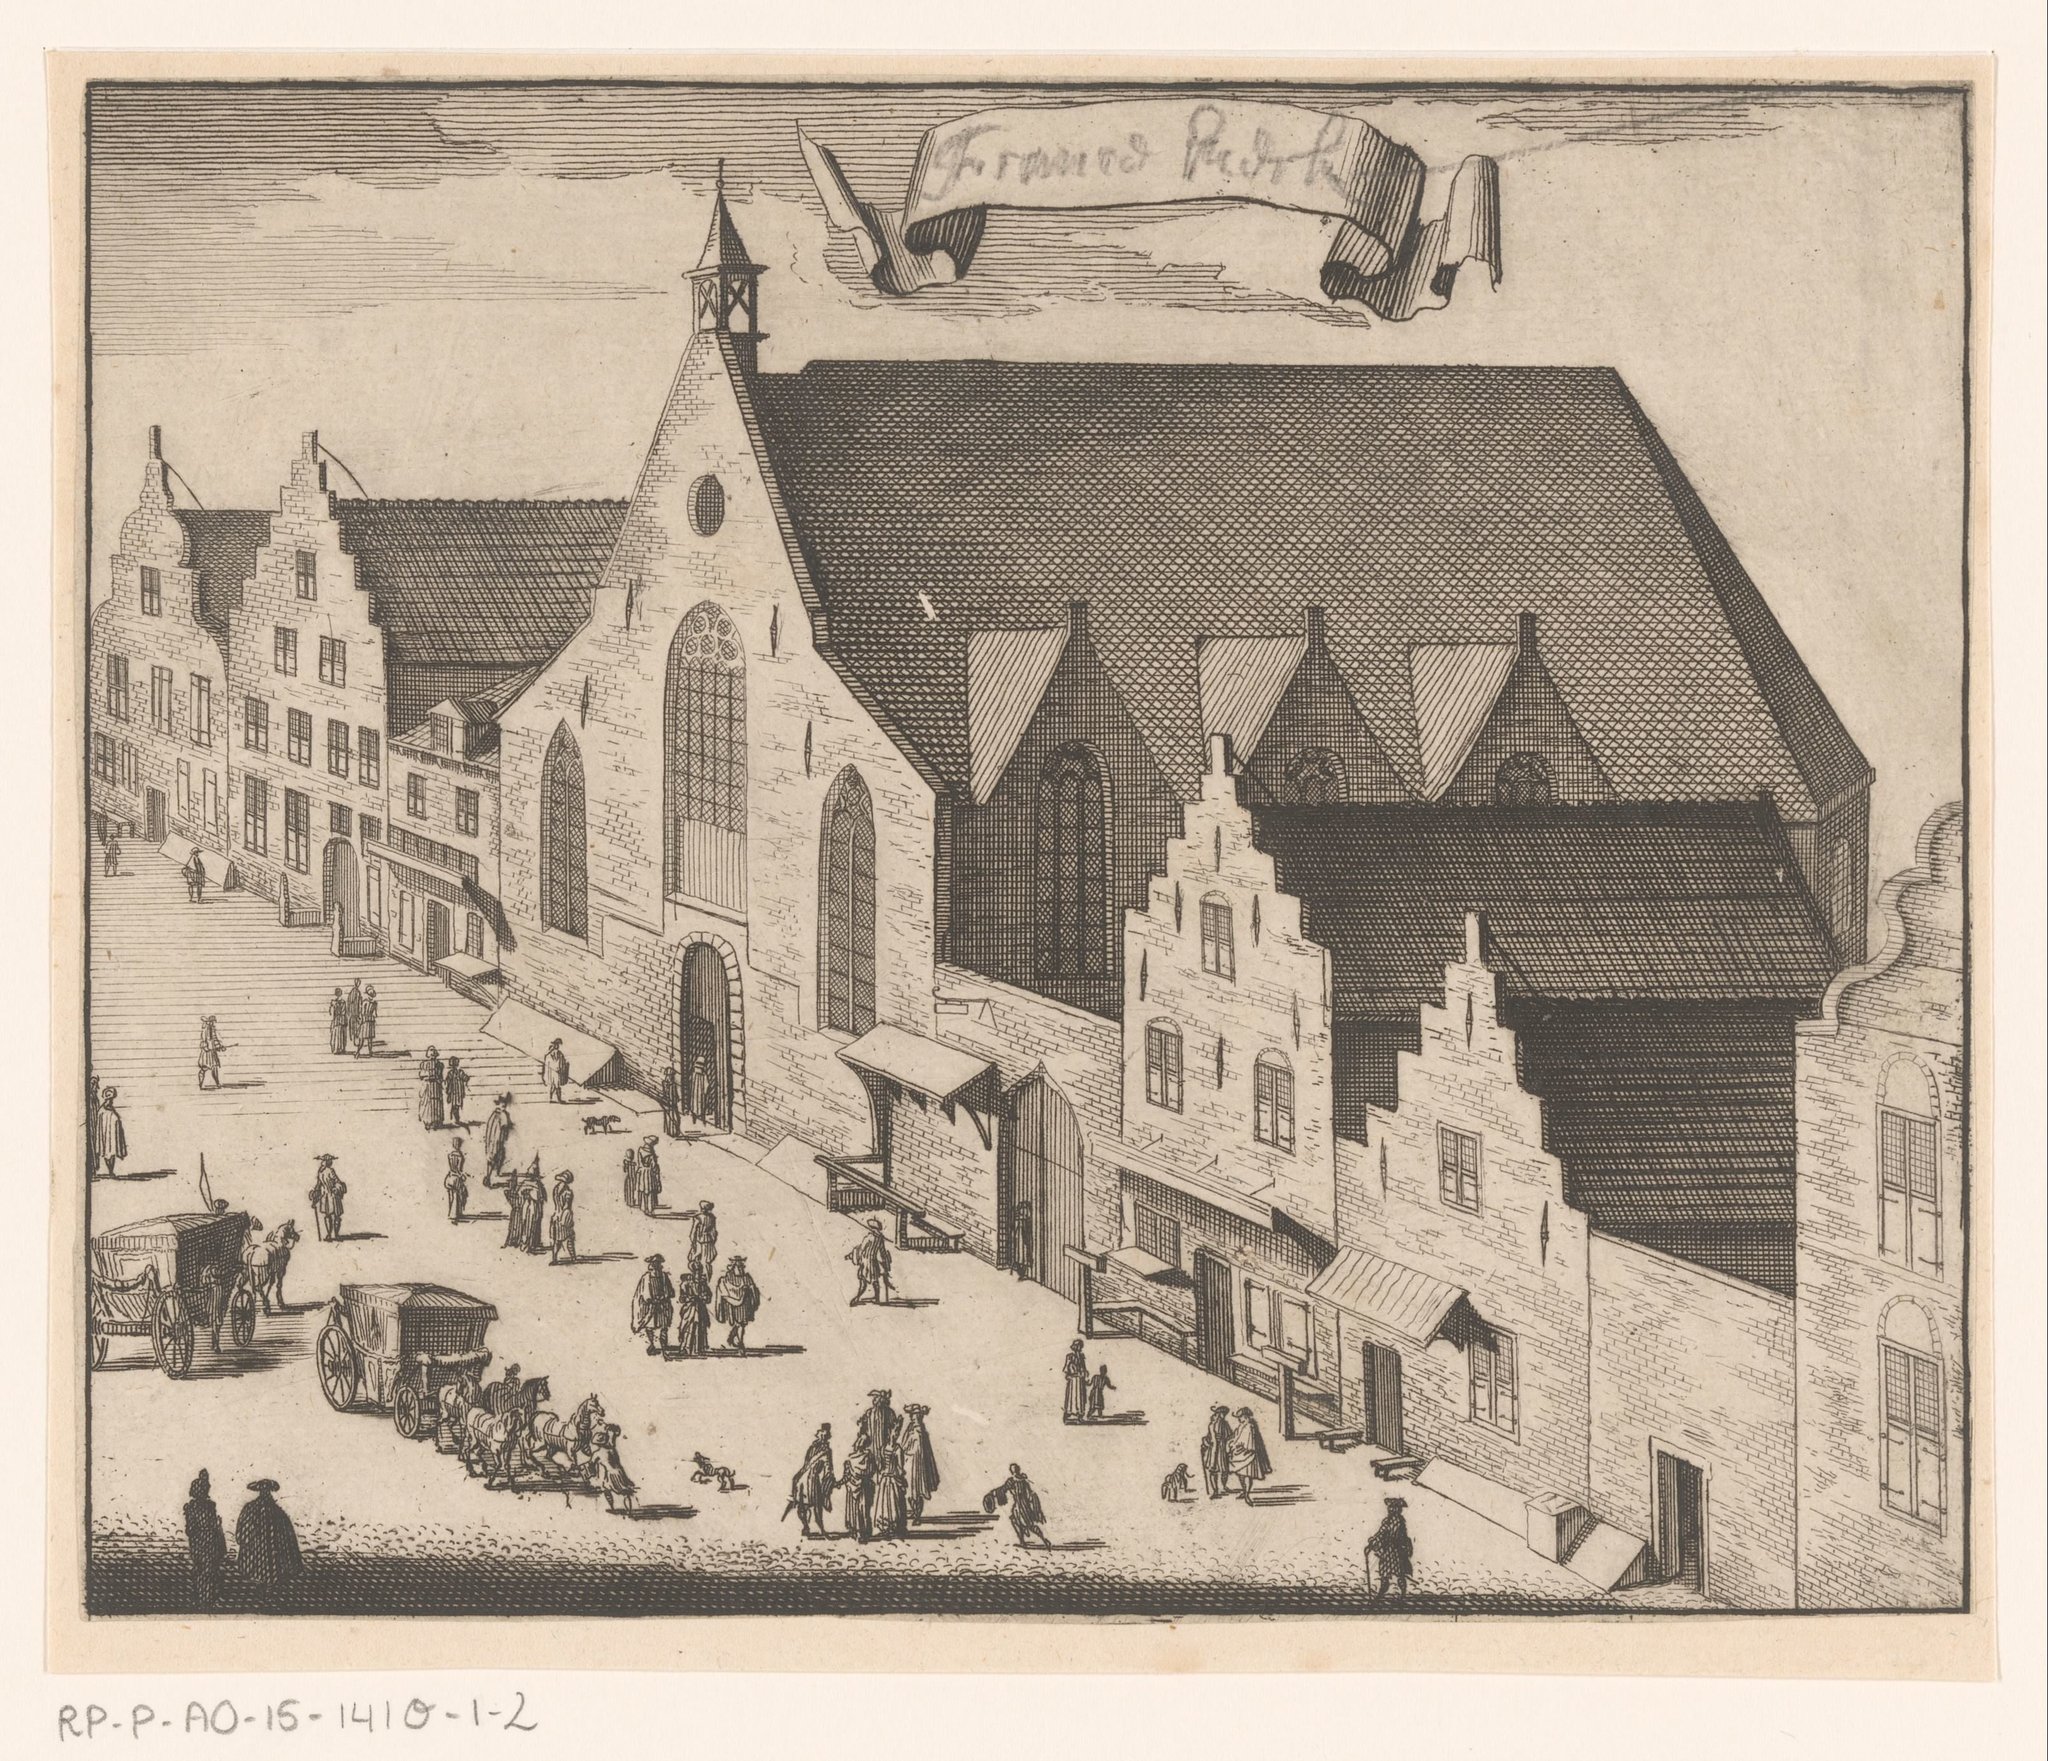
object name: print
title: Gezicht op de Waalse Kerk te Middelburg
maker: Anonymous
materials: paper, pencil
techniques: engraving, etching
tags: church (exterior)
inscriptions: inscription: ‘France Kerk’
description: Oorspronkelijk van één plaat gedrukt met drie andere voorstellingen. Latere staat van prent in zijn geheel ook gebruikt in: Smallegange, Mattheus. Nieuwe Cronyk van Zeeland (…). Middelburg en Amsterdam: Johannes Meertens en Abraham van Someren, 1696. Huidige voorstelling later (plaat mogelijk versneden) met andere voorstelling van andere plaat en apart gedrukte sierrand ook gebruikt in: Aa, Pieter van der. La galerie agreable du monde (...). 66 delen. Leiden: Pieter van der Aa, 1728, dl. 20. Zie RP-P-AO-15-141O-1-1 voor latere staat.